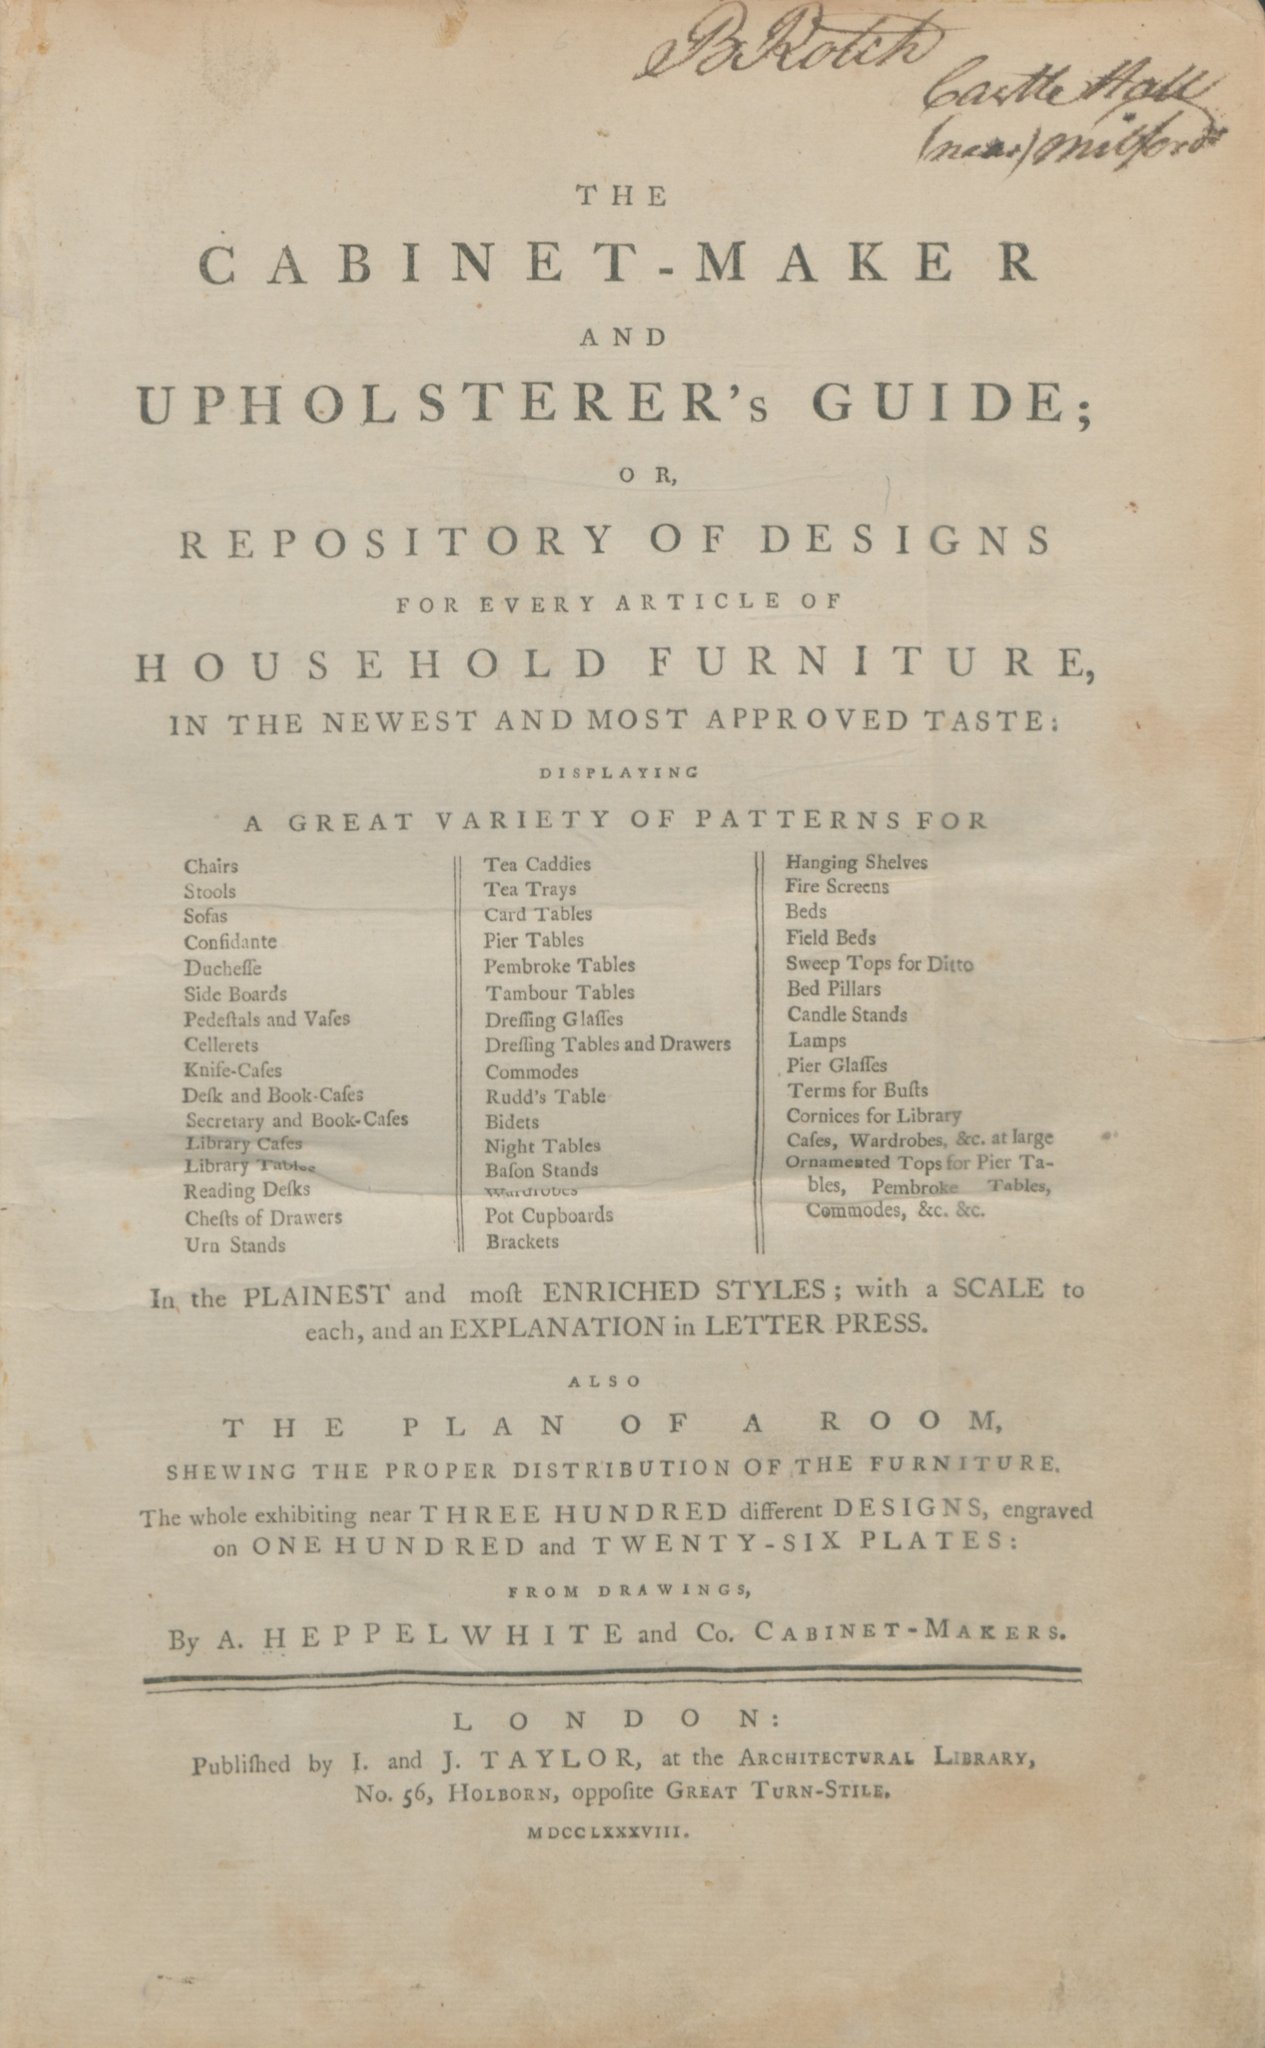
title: The cabinet-maker and upholsterer's guide, or, Repository of designs for every article of household furniture, in the newest and most approved taste : displaying a great variety of patterns for chairs, stools ... in the plainest and most enriched styles : with a scale to each, and an explanation in letter press : also the plan of a room, shewing the proper distribution of the furniture ... from drawings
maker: a. hepplewhite & co.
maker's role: author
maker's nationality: british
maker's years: 1750-1800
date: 1788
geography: london